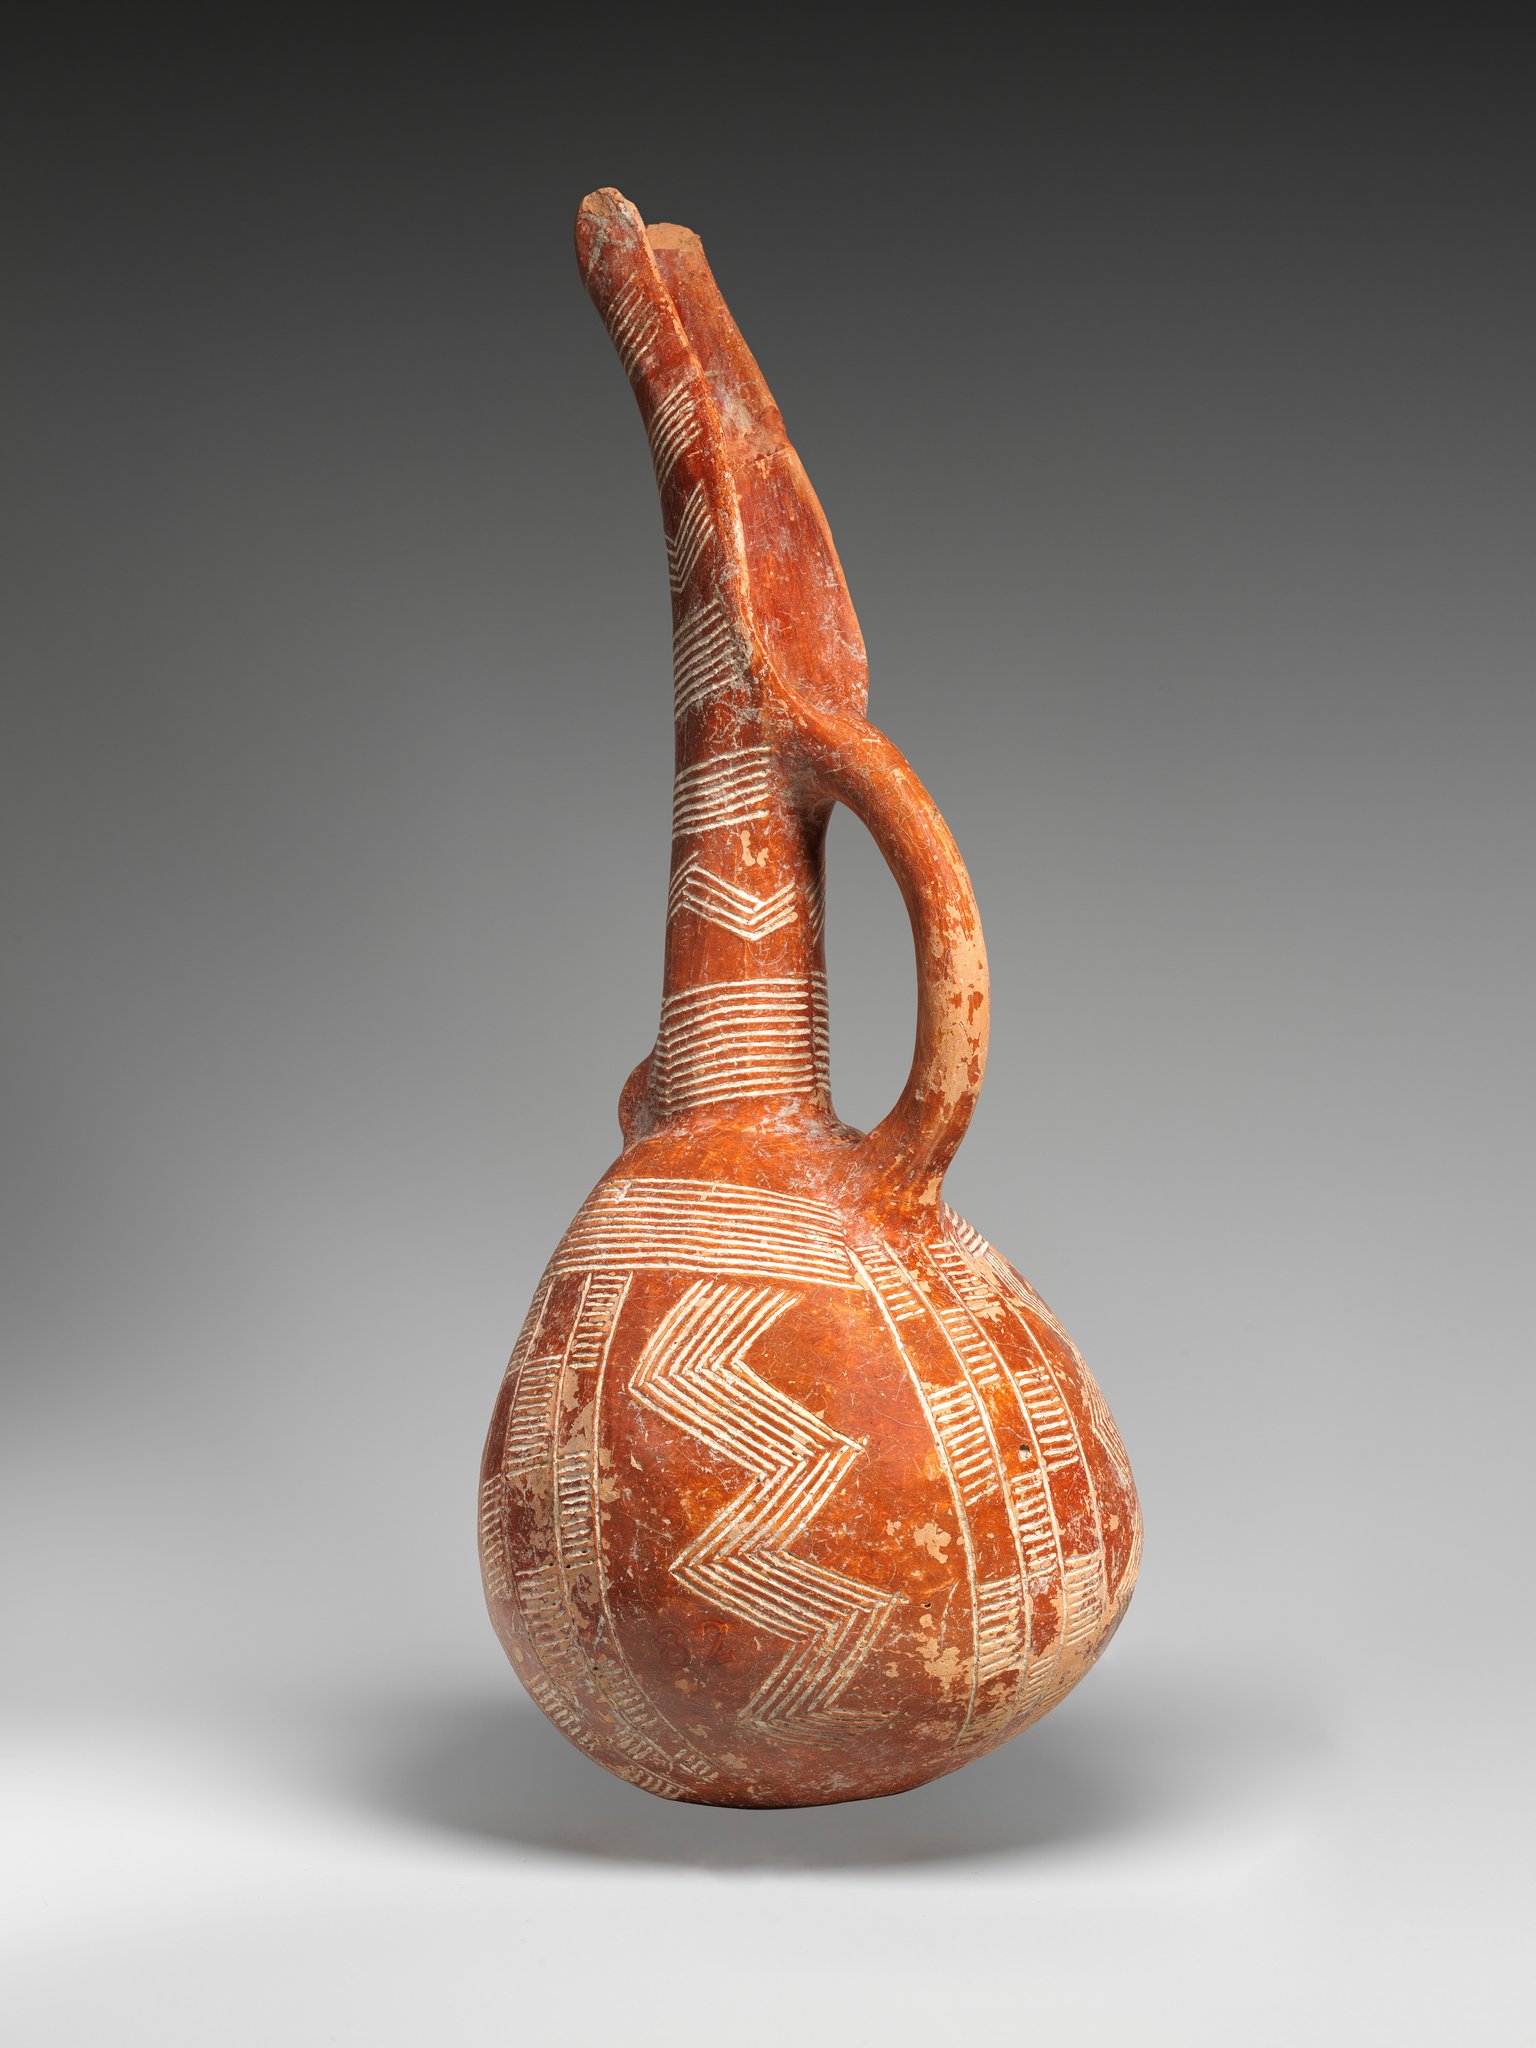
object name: jug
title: Terracotta jug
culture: cypriot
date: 2000-1800 BCE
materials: terracotta